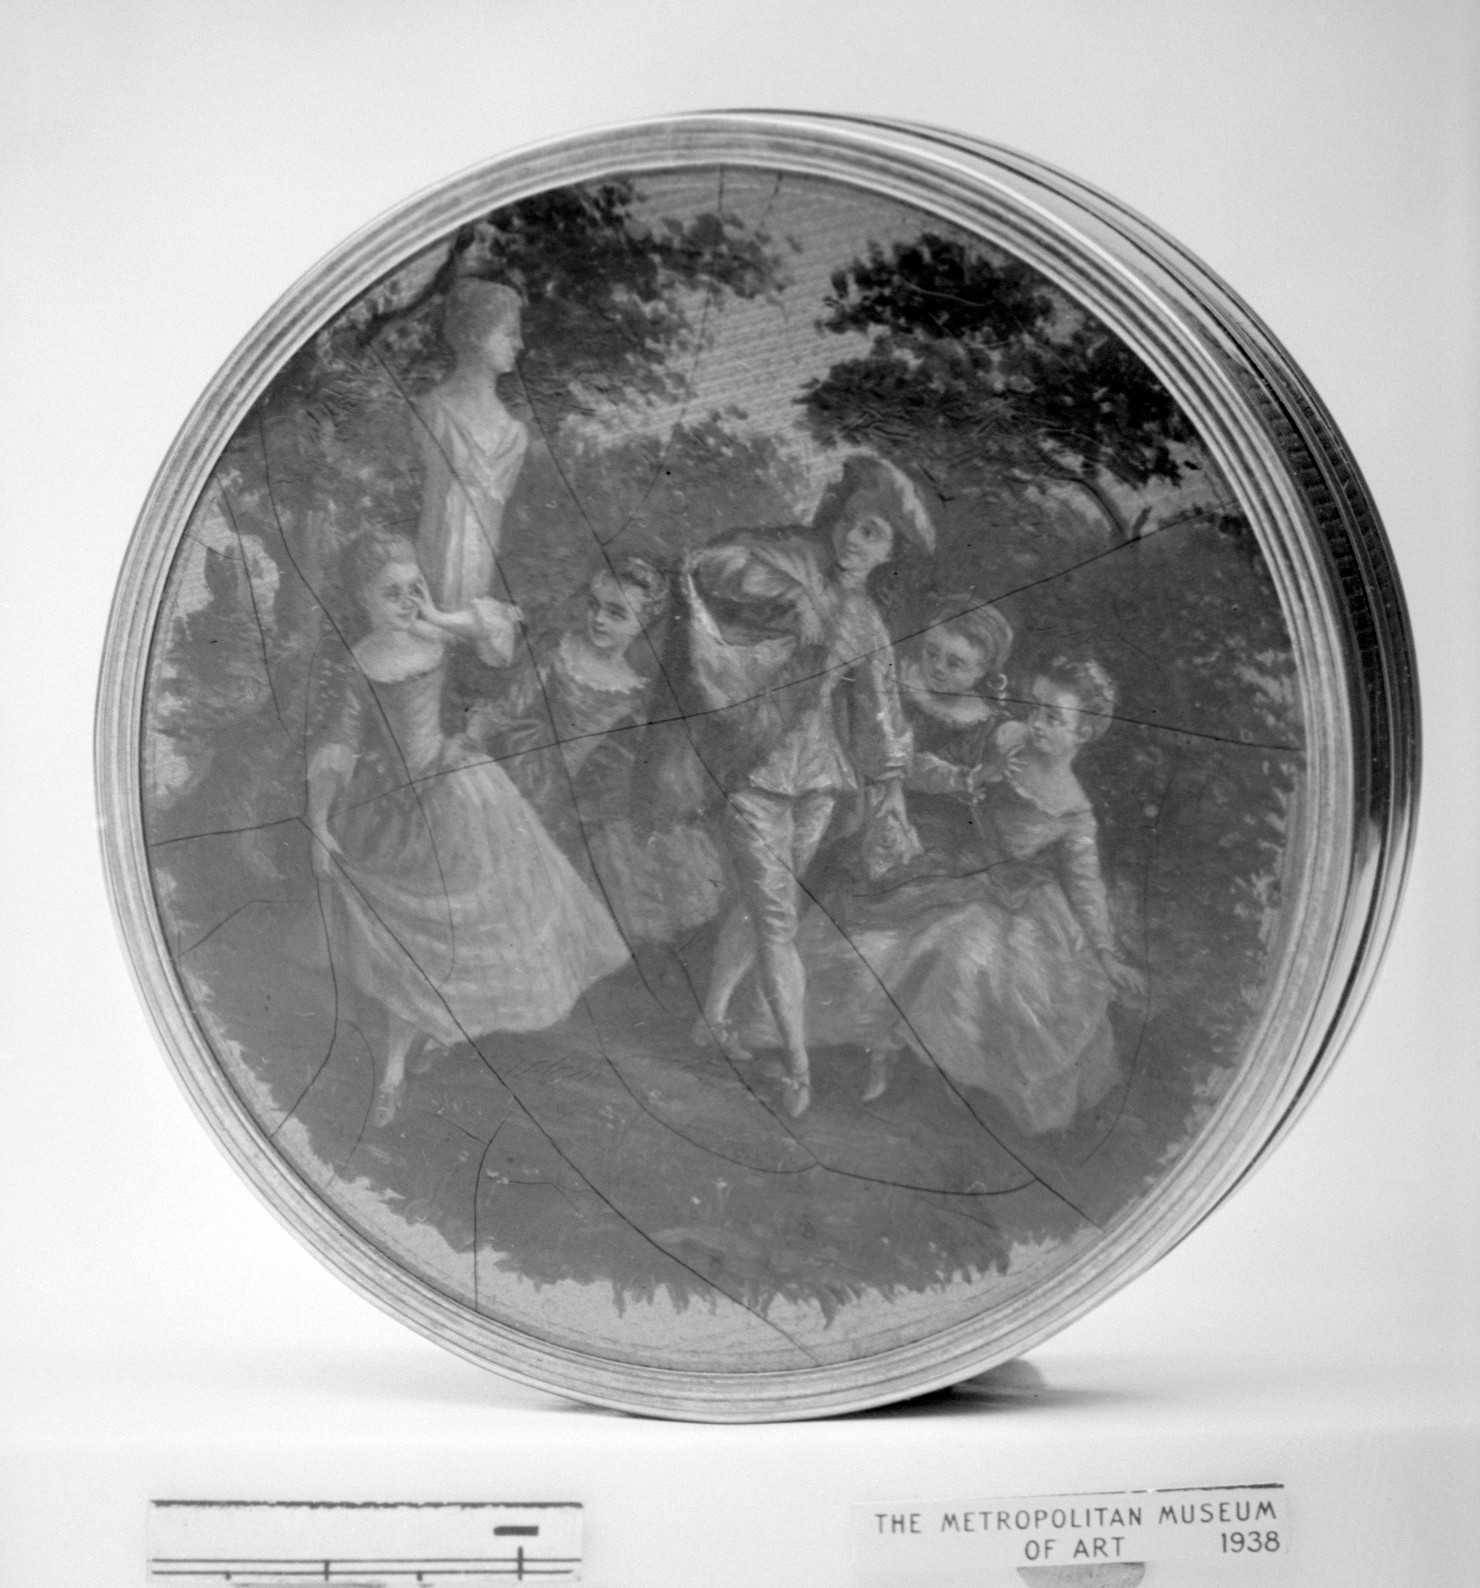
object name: box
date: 1701-1800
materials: silver gilt, wood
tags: boys,girls